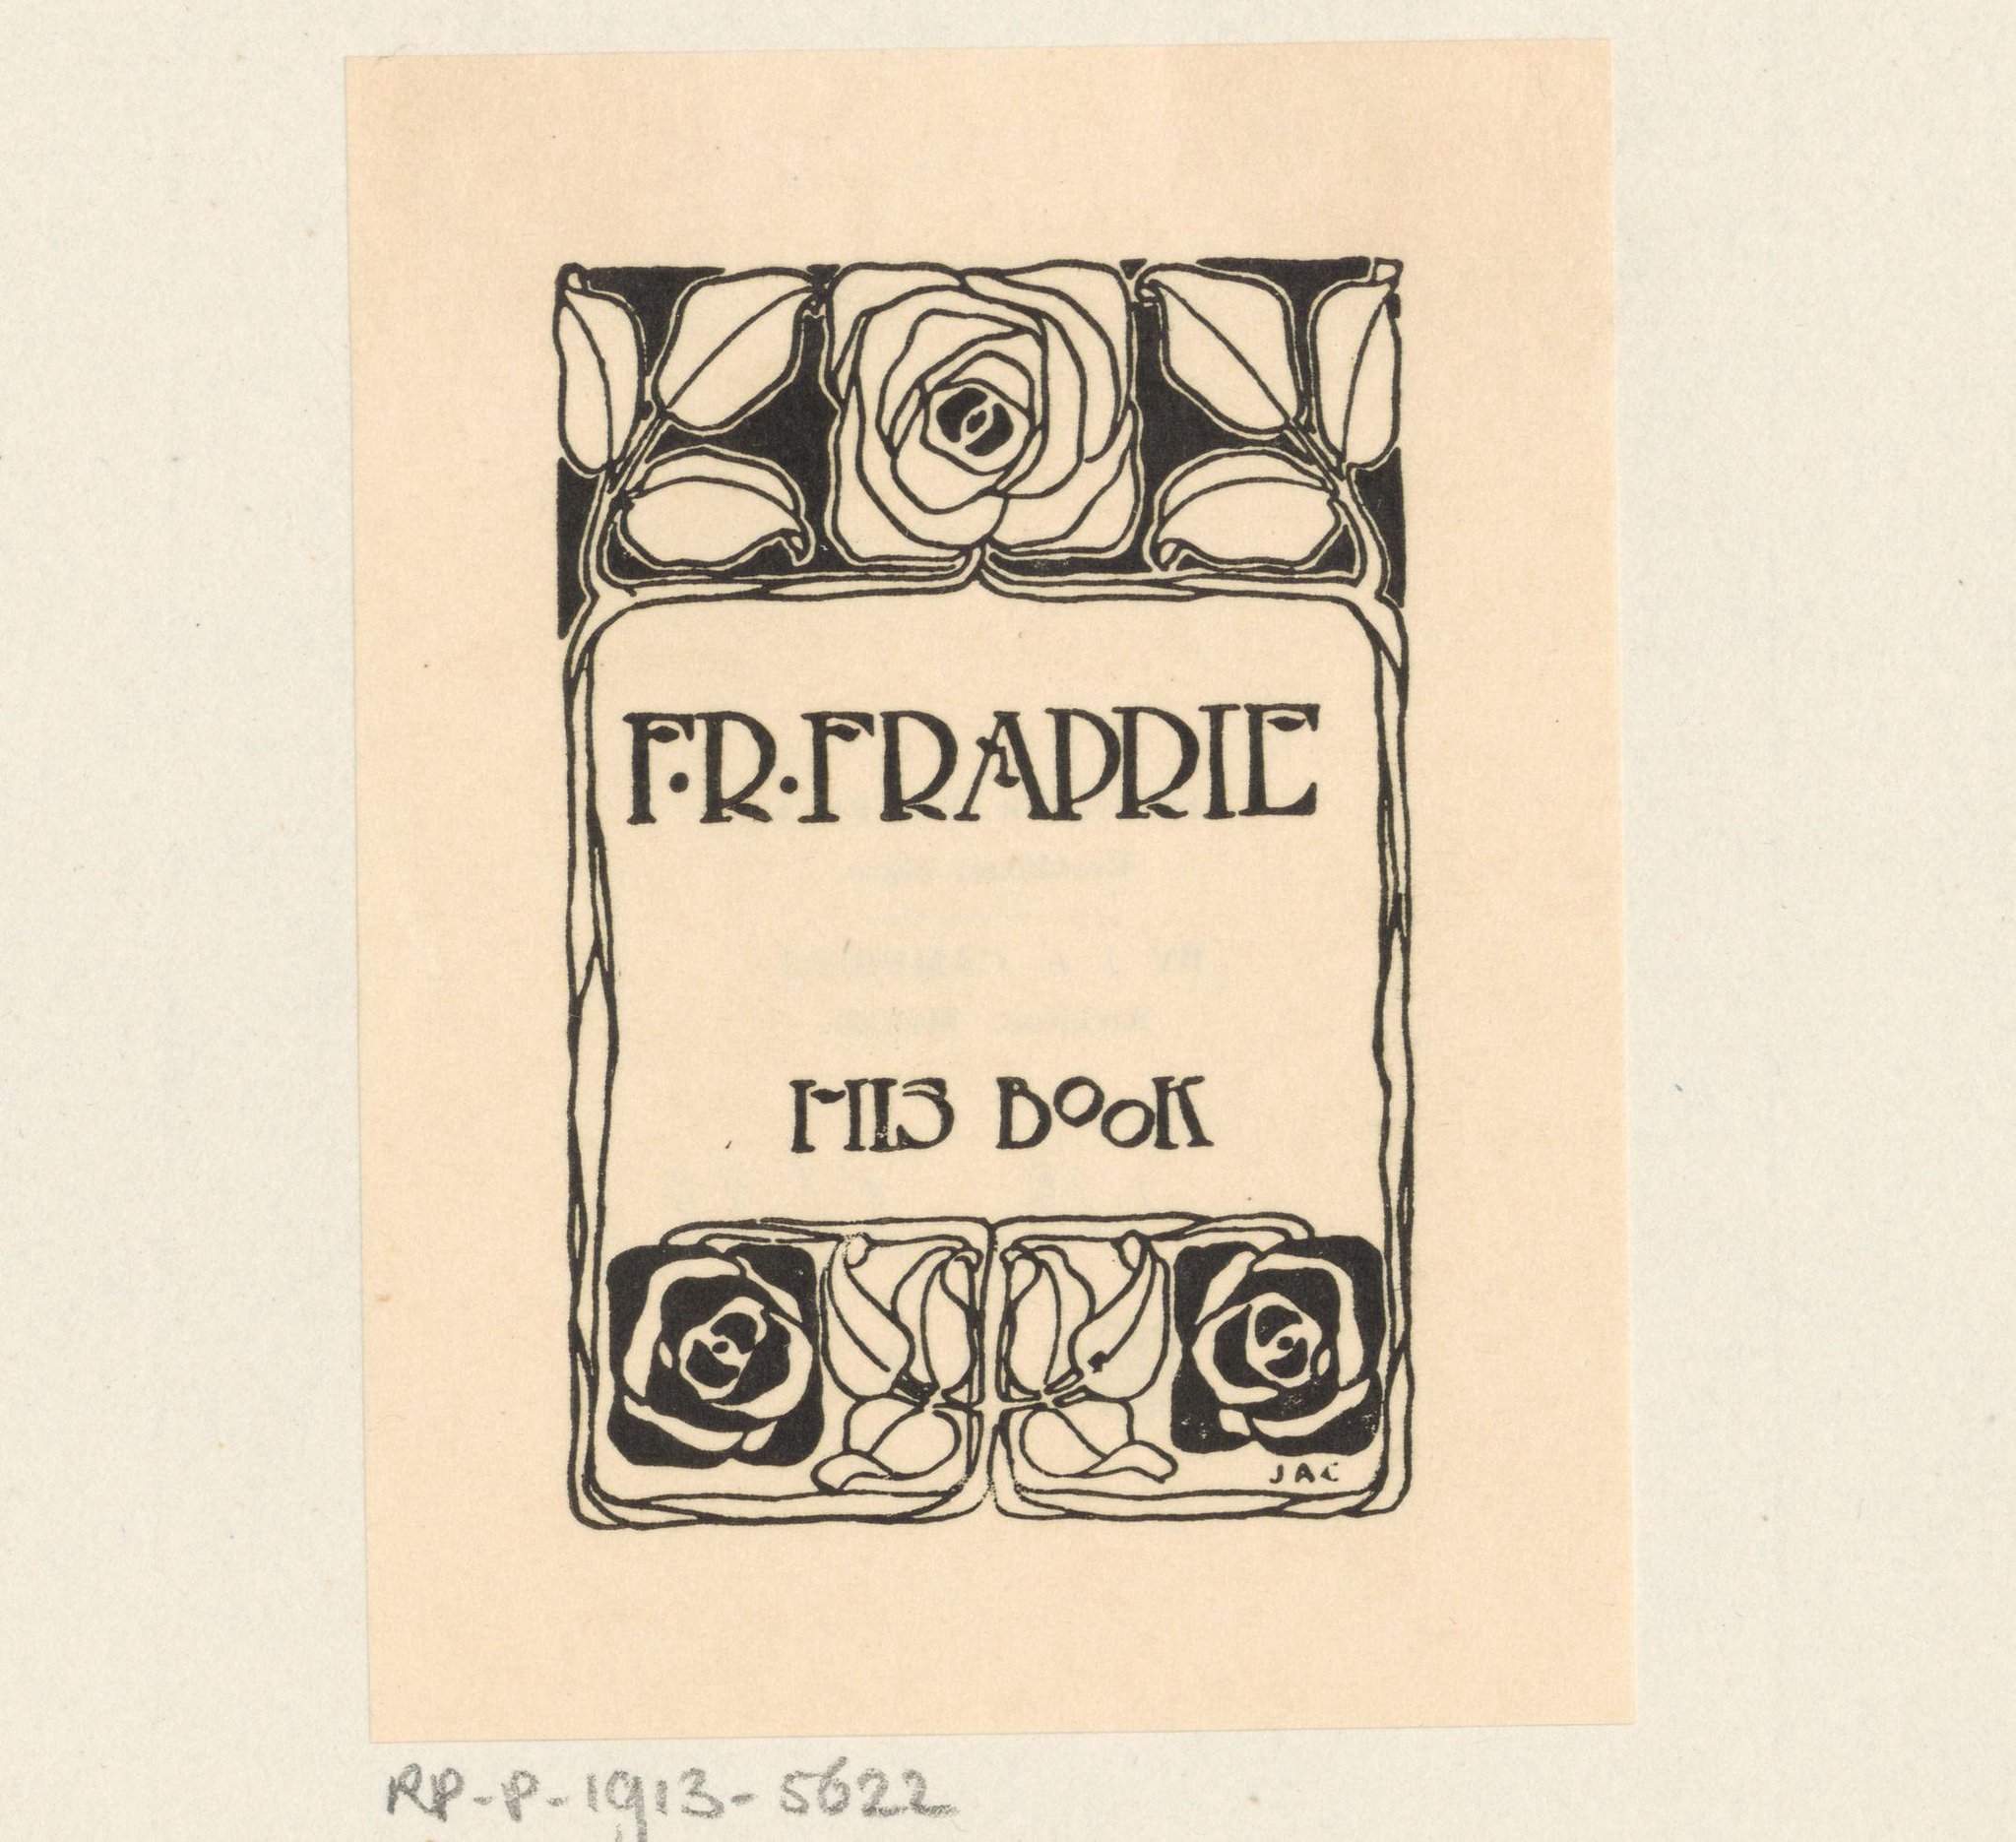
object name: bookplate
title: Ex libris van Frank Roy Fraprie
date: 1905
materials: paper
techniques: printing block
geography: munich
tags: flowers: rose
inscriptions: inscription: ‘Frank R. Fraprie/ Brooklyn, Mass./ By J.A. Campbell/ Architect, Munich.’, collector's mark: Lugt 2233, collector's mark: Lugt 2760